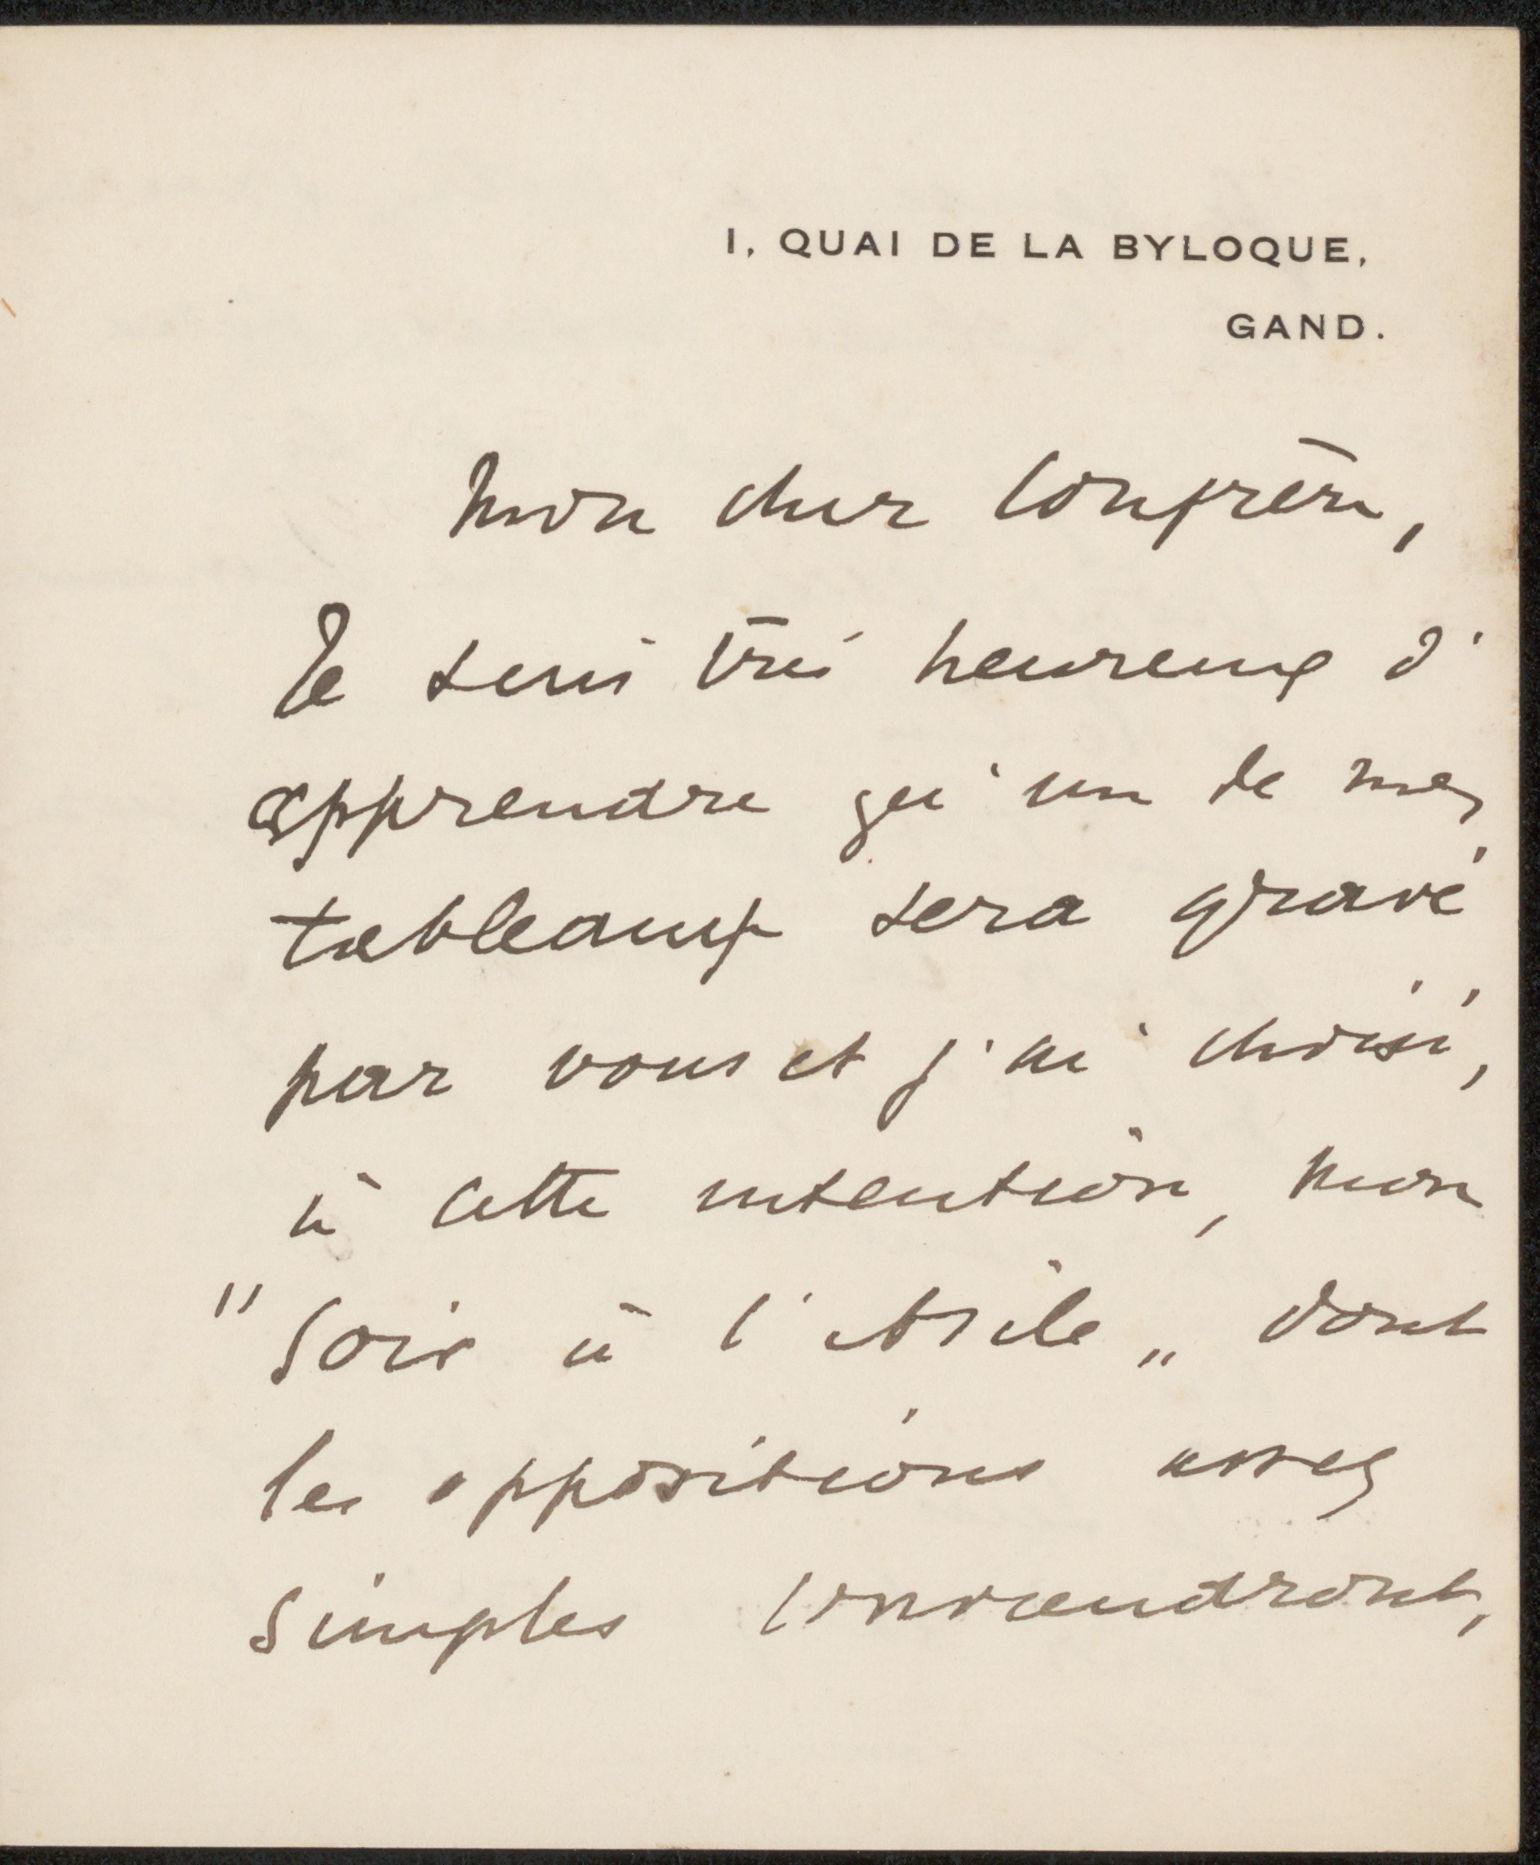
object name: letter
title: Brief aan Philip Zilcken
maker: albert baertsoen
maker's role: draughtsman, print maker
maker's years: 1866-1922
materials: ink, paper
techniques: pen, printing, writing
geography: ghent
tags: the hague, philip zilcken, sending and receiving postal matter, the graphic arts, painting (including book-illumination, miniature-painting)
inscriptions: watermark, collector's mark: ‘RPK’